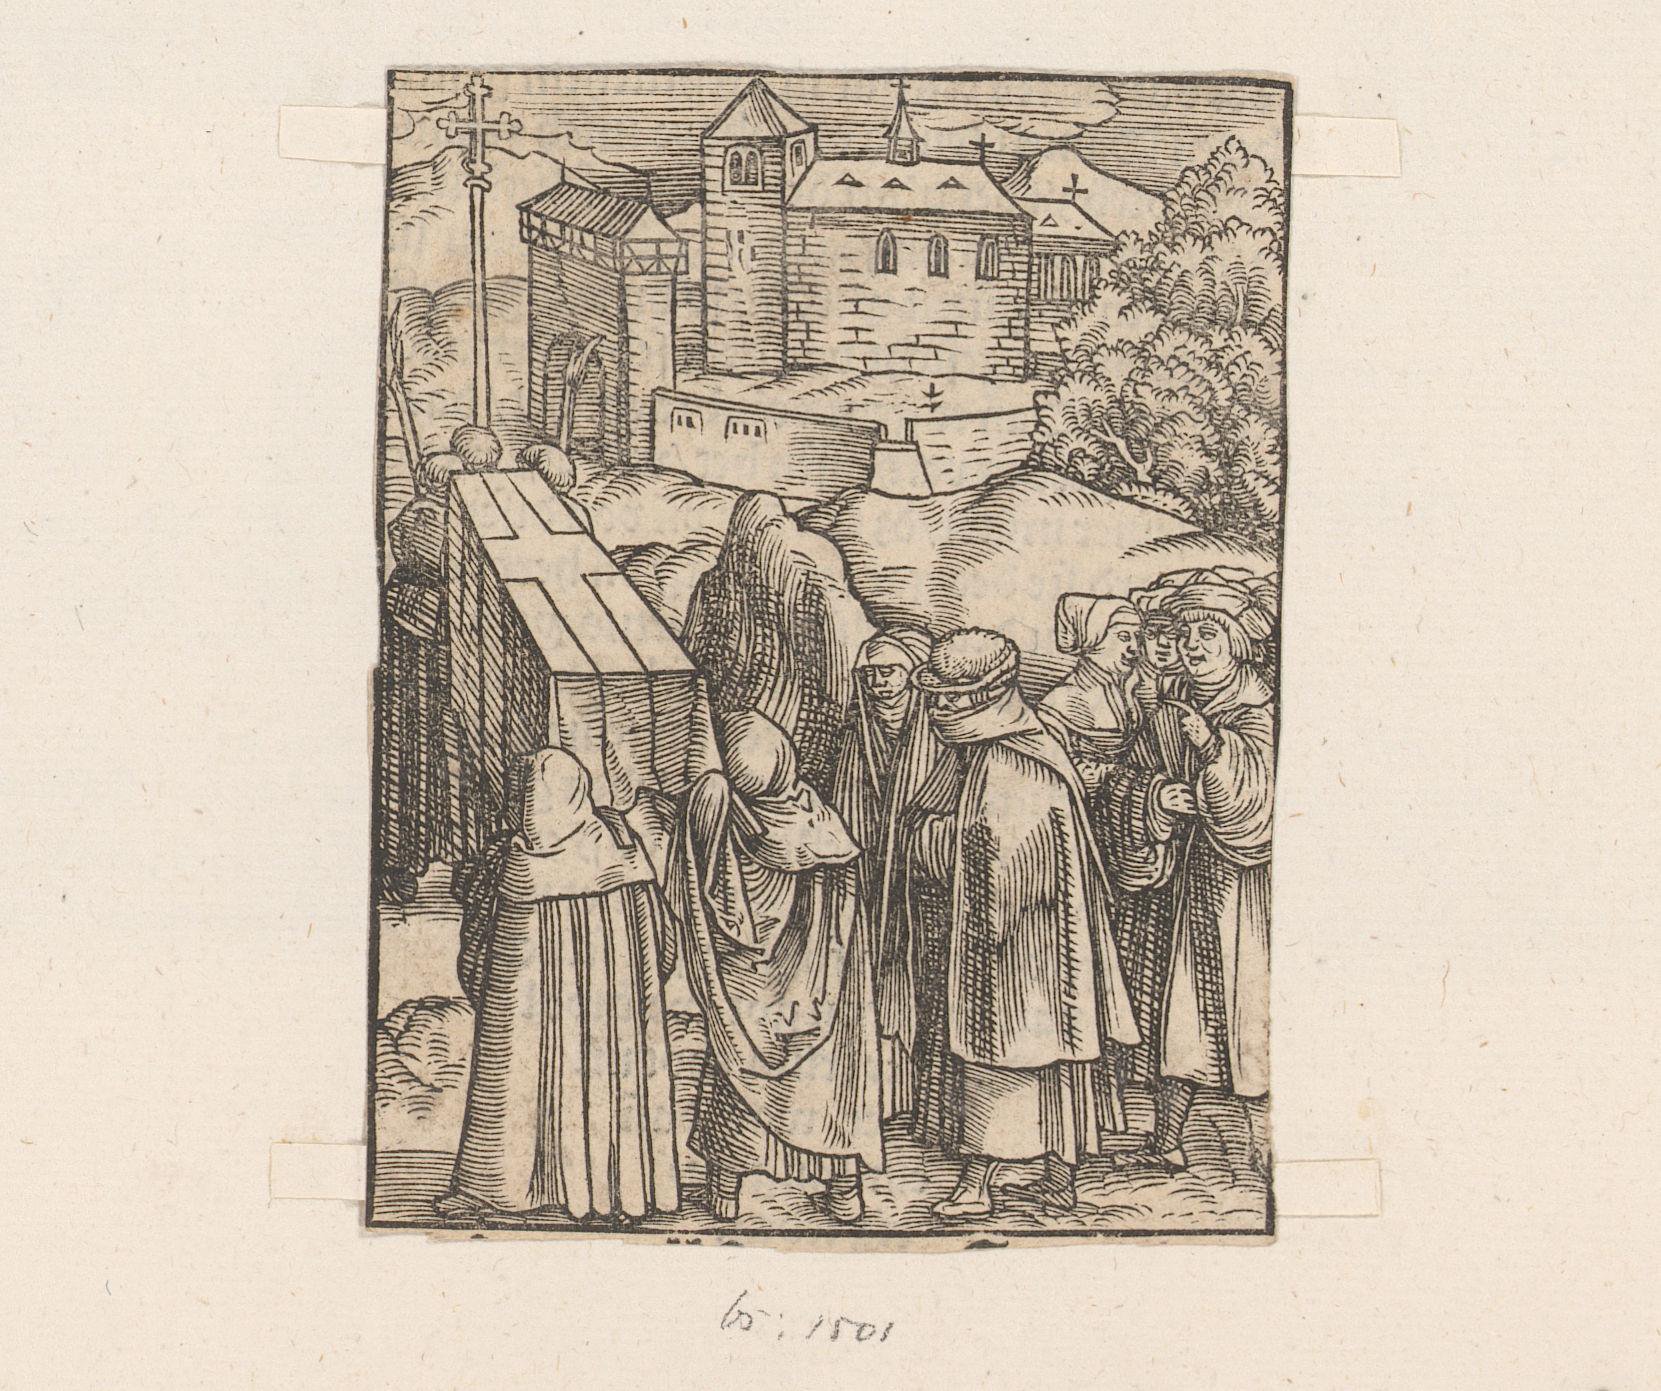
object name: book illustration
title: Uitvaart van de Heilige Brigitta van Zweden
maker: Anonymous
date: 1500-1600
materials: paper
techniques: woodcut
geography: germany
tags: the foundress of the order of bri(d)gettines, the widow bridget (birgitta) of sweden; possible attributes: band over veil with five red spots, book, candle, heart with cross, inkhorn, pilgrim's hat, staff, wallet - death, deathbed of female saint